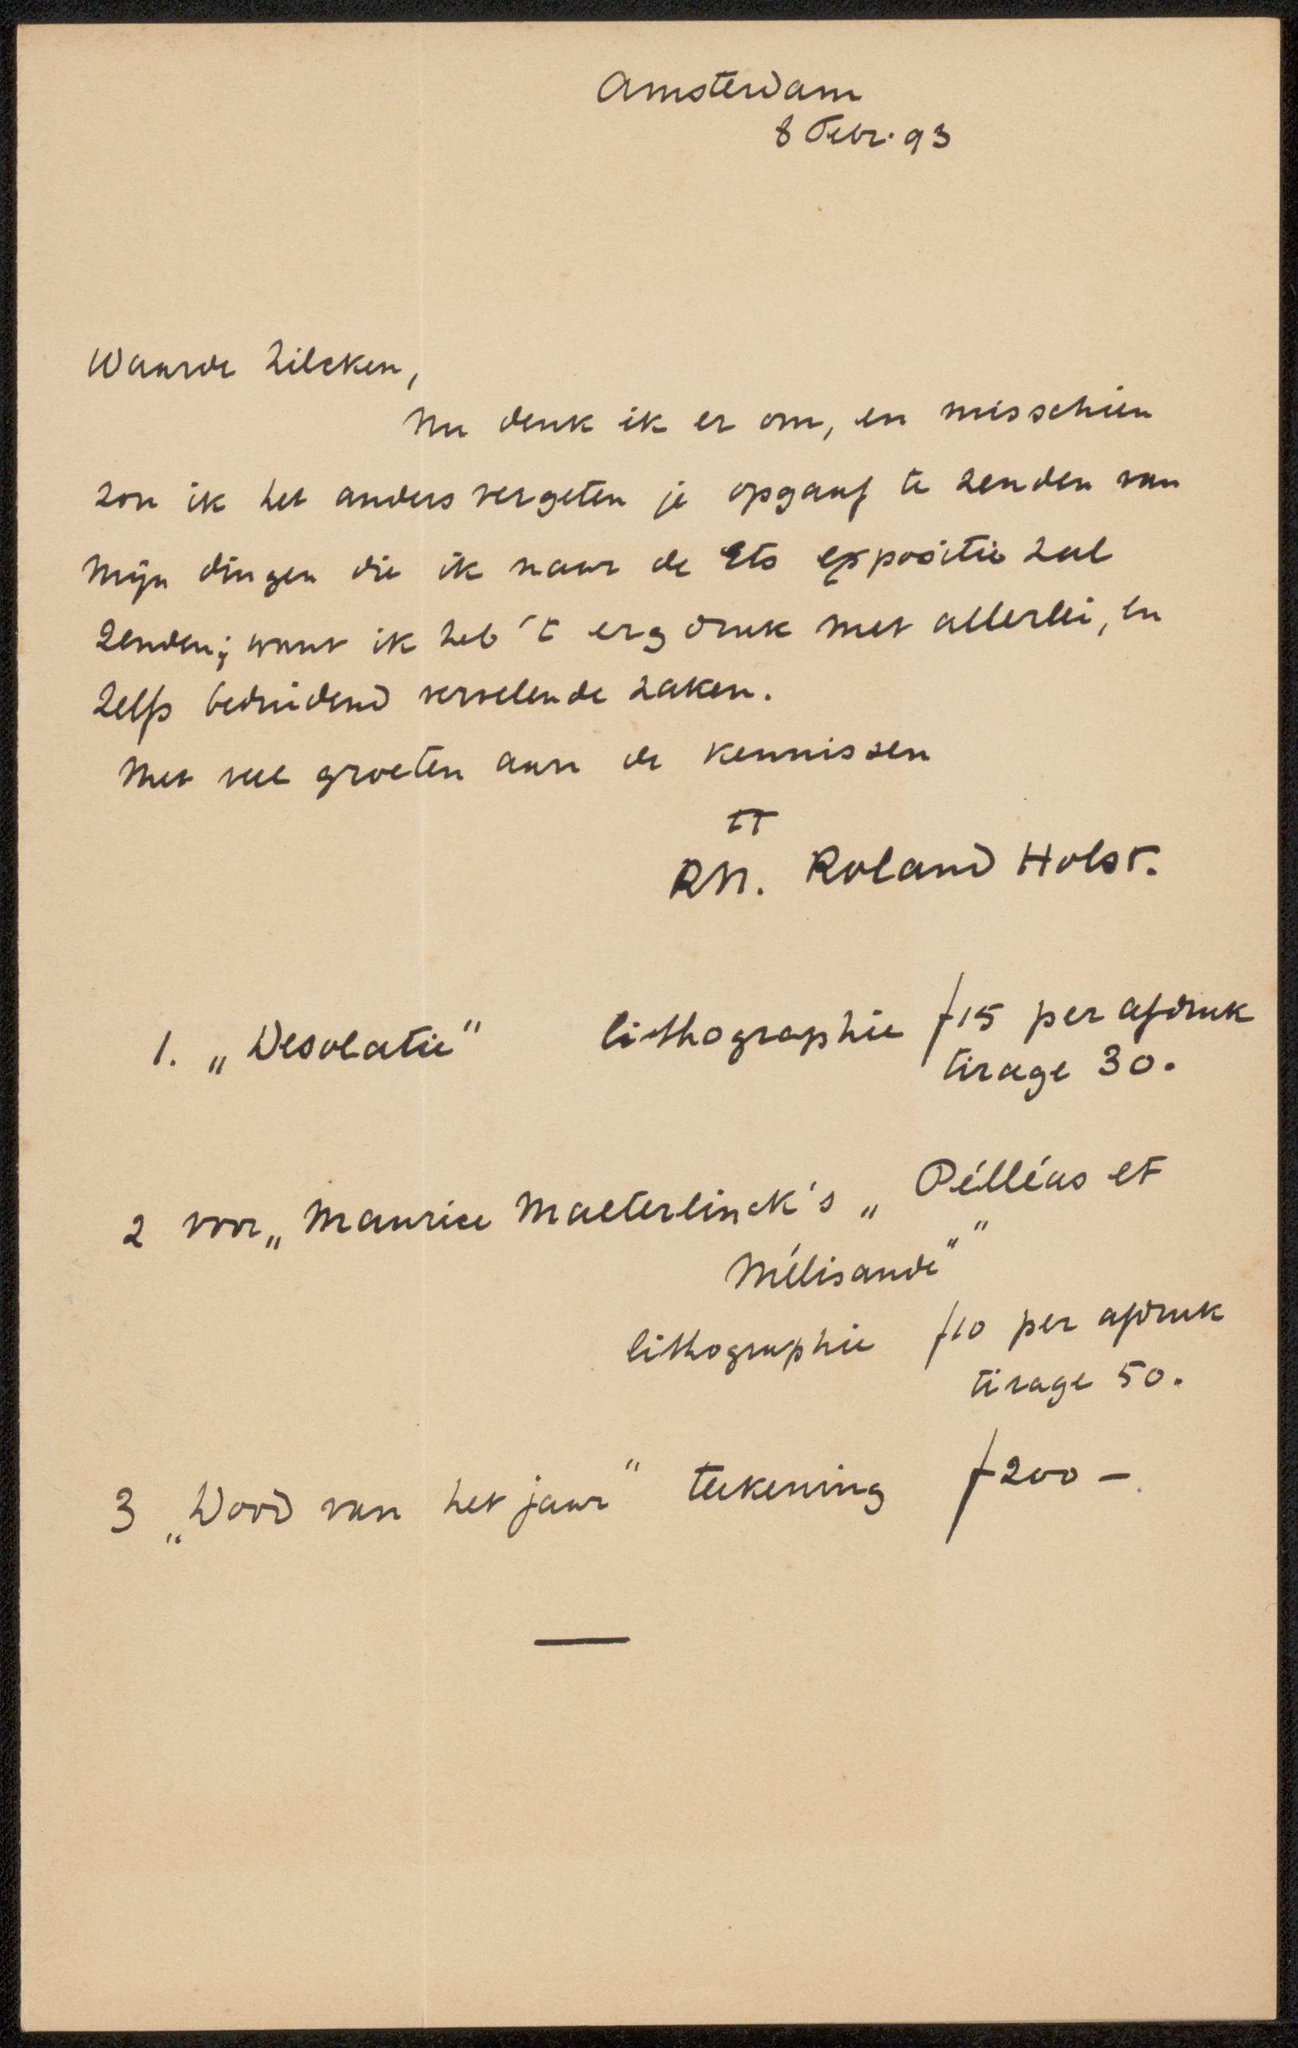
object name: letter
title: Brief aan Philip Zilcken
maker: richard nicolaüs roland holst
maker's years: 1868-1938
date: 1893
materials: ink, paper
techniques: pen, writing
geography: amsterdam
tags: the hague, painter, draughtsman, philip zilcken, drawing, the graphic arts, exhibition ~ art, money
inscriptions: collector's mark: ‘RPK’